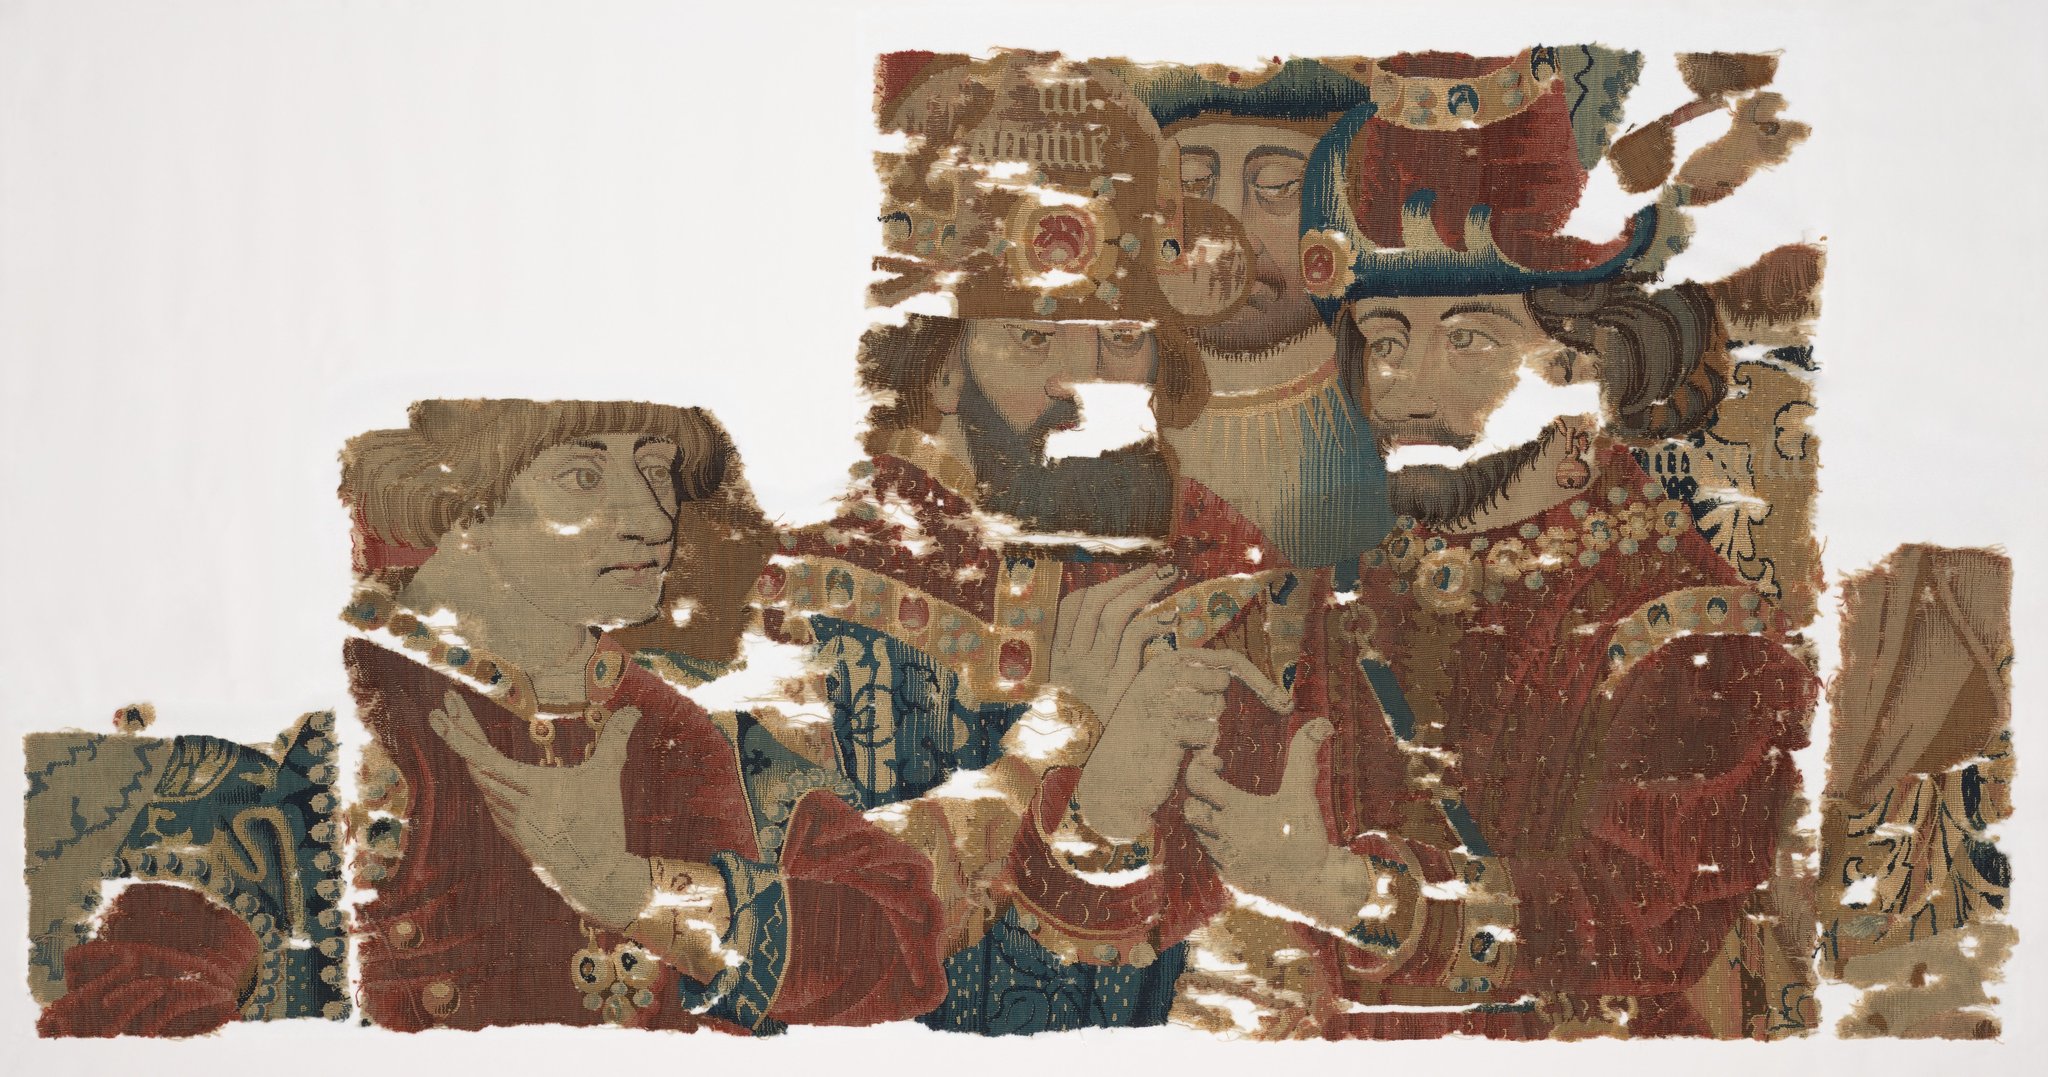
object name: tapestry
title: Busts of Achilles, Agamemnon, and Hector in Conference (from Scenes from The Story of The Trojan War)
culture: south netherlandish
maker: pasquier grenier of tournai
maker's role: artist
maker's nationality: burgundian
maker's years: 1393-1493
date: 1470-1490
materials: silk, wool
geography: south netherlands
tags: trojan war,achilles,agamemnon